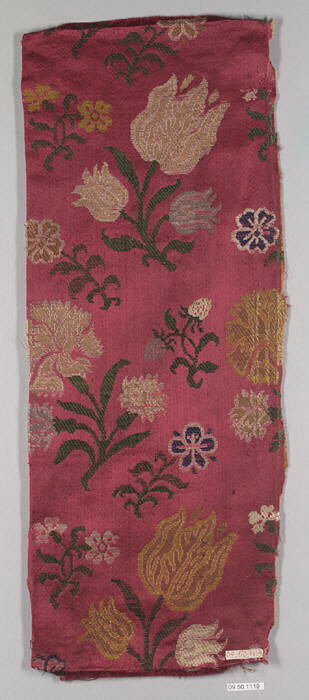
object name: piece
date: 1701-1800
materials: silk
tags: flowers